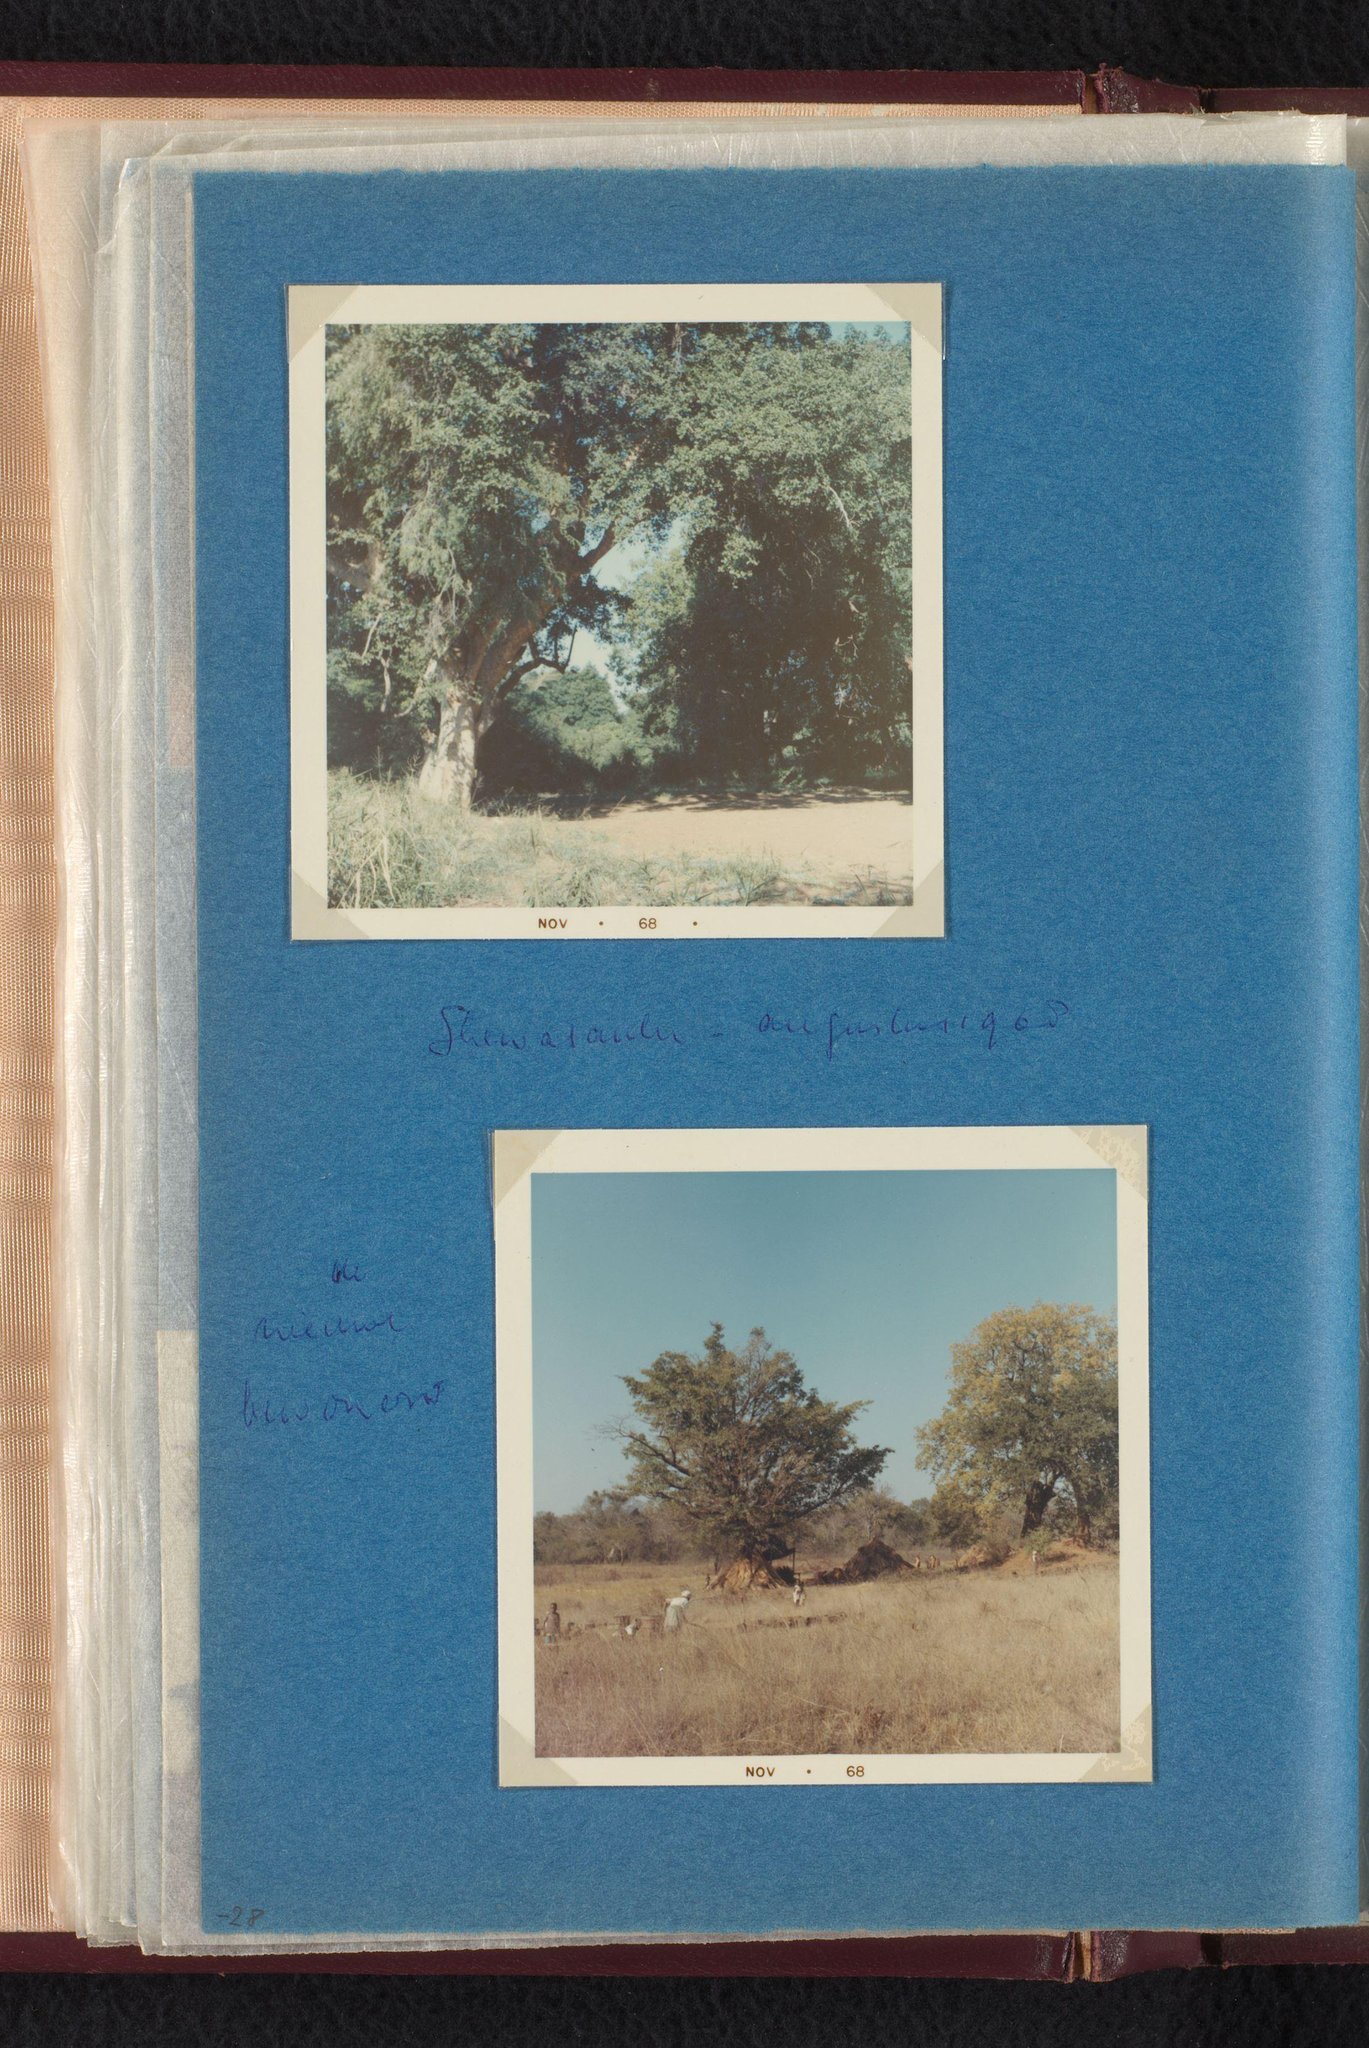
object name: photograph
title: De nieuwe bewoners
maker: willem jacob van den berg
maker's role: boer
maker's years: 1902-1983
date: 1911-1968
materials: paper, cardboard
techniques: chromogenic print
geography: shewasaulu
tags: soil cultivation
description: Deze foto's zijn onderdeel van een album.